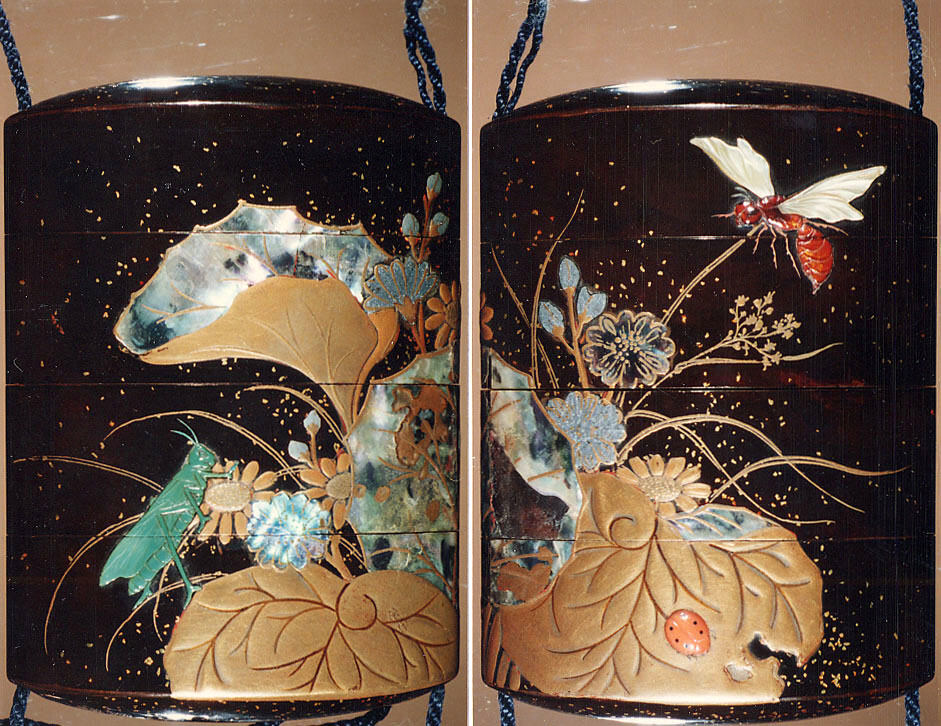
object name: inrō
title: Case (Inrō) with Design of Flowering Plants with Dragonfly and Insects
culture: japanese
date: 1801-1900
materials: gold, ivory, lacquer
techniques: fundame, hiramakie, roiro, stain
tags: insects,dragonflies,flowers